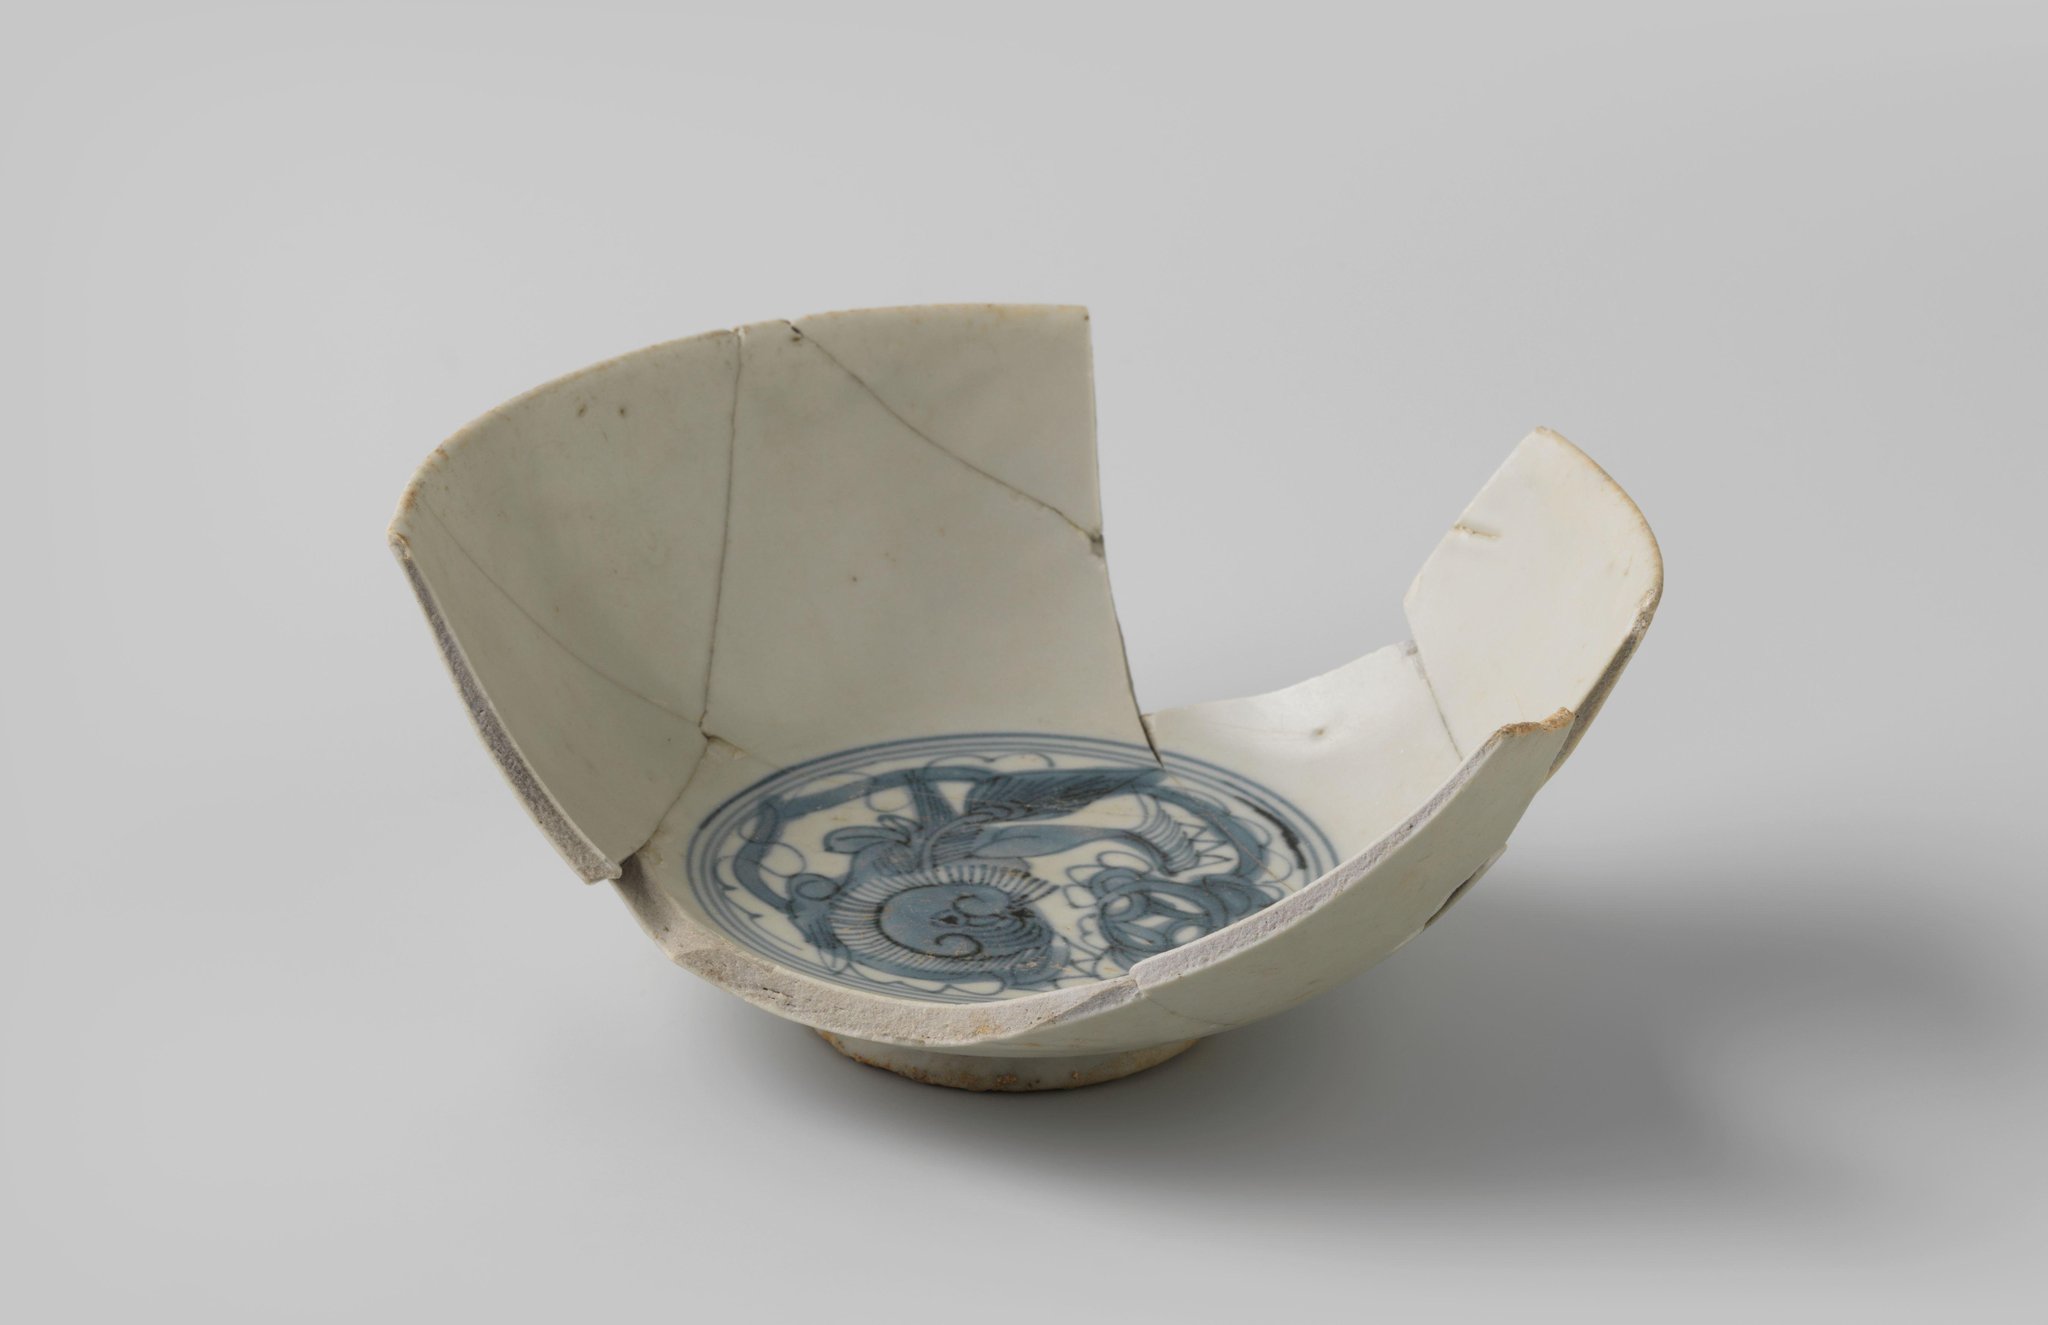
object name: bowl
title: Fragment kom uit V.O.C.-schip de 'Witte Leeuw'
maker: Anonymous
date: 1613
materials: porcelain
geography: shantou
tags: verenigde oostindische compagnie, sint-helena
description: A bowl. In the centre is a dog of fu with a ball, encircled by three thin bands. The inside and outside walls are blank. is drawn around the footring and one around the lip-rim.